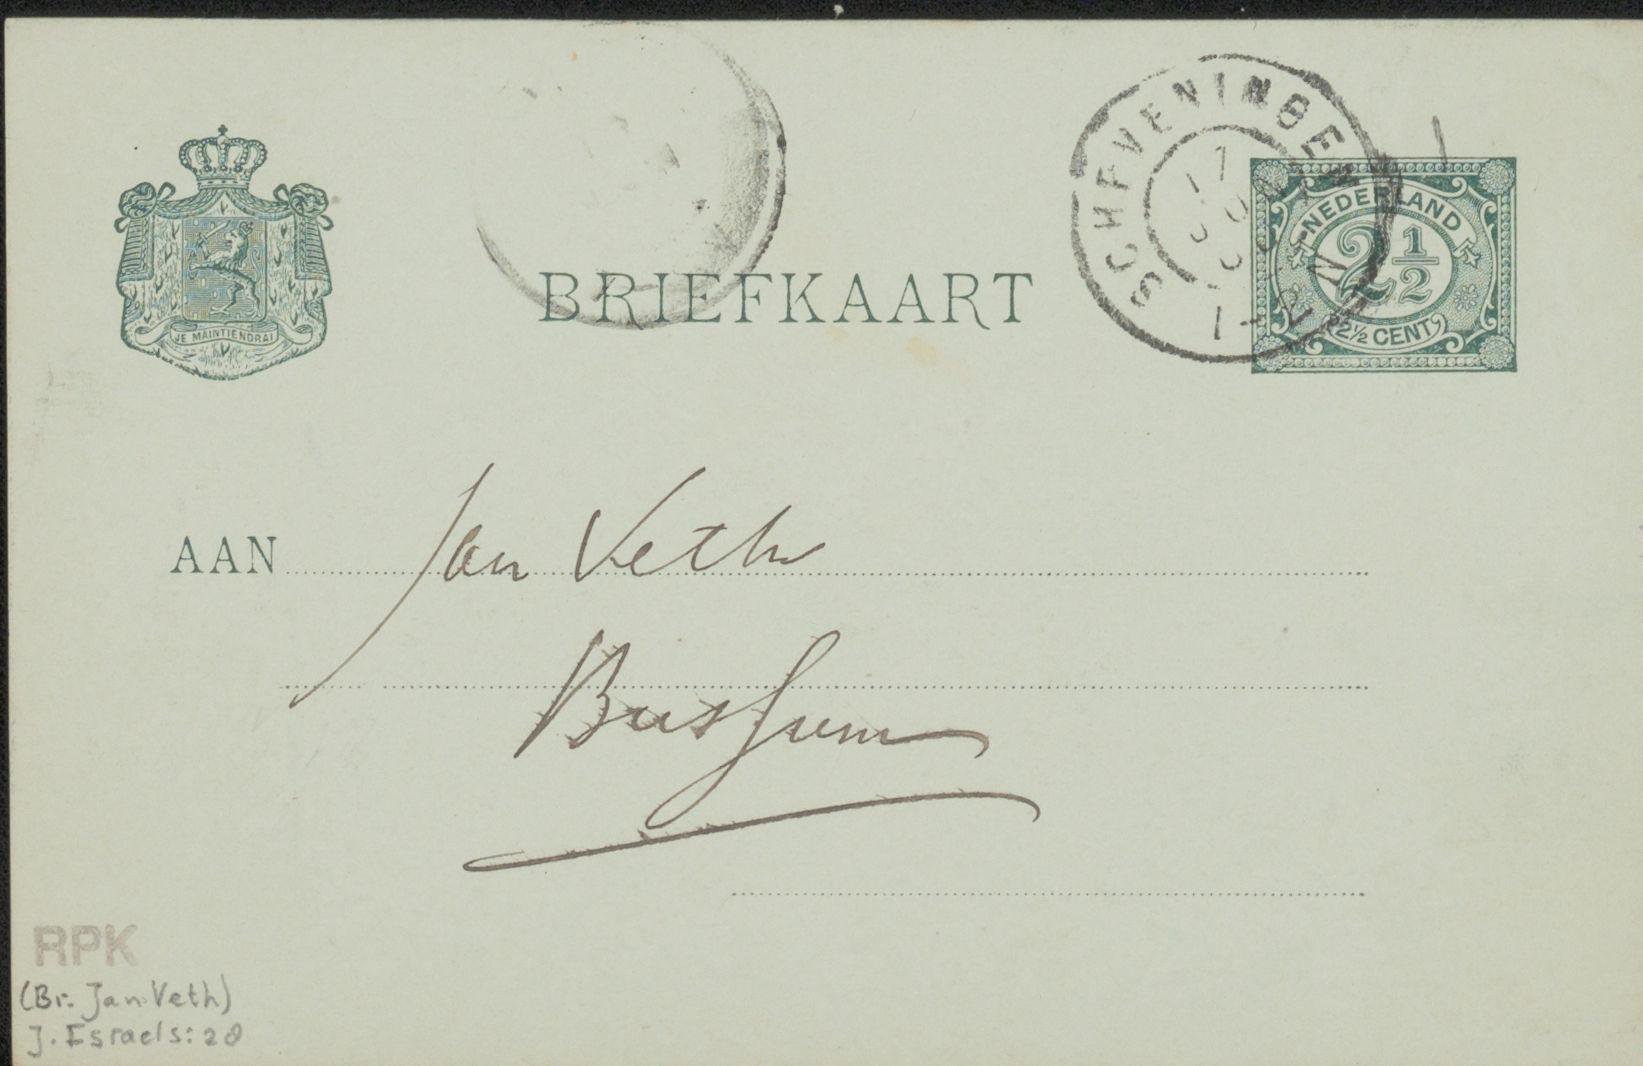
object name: postcard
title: Briefkaart aan Jan Veth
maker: jozef israëls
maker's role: draughtsman, painter, print maker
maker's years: 1824-1911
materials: cardboard, ink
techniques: pen, writing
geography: scheveningen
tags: jan veth, antwerp, frans hals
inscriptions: collector's mark: ‘RPK’